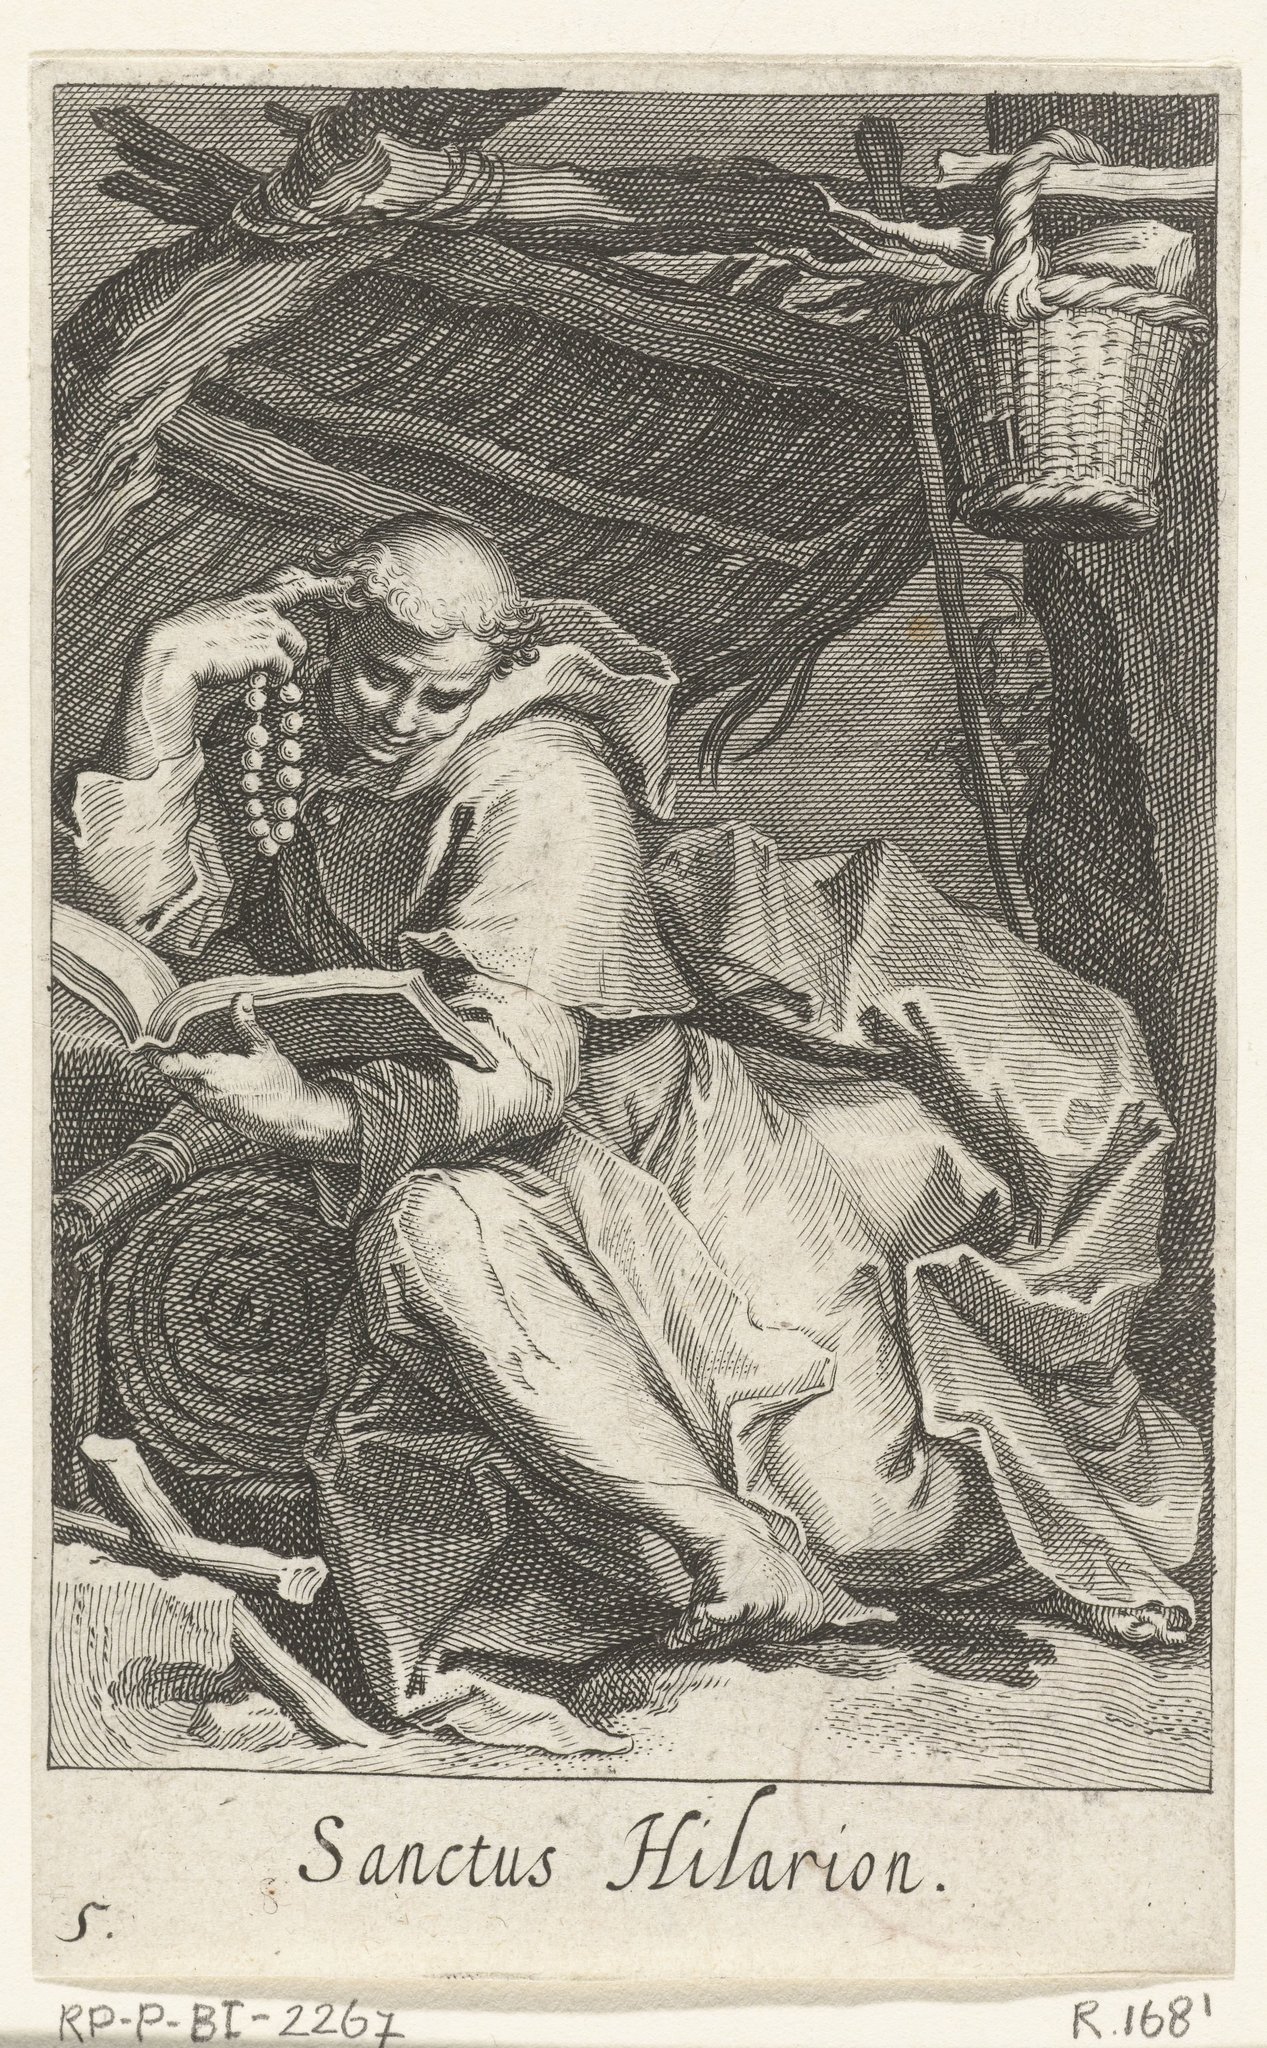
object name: book illustration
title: Kluizenaars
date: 1590-1612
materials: paper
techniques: engraving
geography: antwerp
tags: anchorite, hermit, hilary (hilarius), bishop of poitiers; possible attributes: serpent(s)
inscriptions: collector's mark: Lugt 240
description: Prent uit: Sacra eremus ascetarum, Antwerpen, Hendrick Aertssen, 1619. Eerste gebonden uitgave met in totaal vijftig prenten. Prent uit serie van vijfentwintig mannelijke kluizenaars. In 1612 verscheen een ongebonden editie maar op basis van de gewijzigde opschriften en samenstelling wordt aangenomen dat de prenten van de uitgave 1619 ook in 1612 of iets daarvoor gedrukt werden. Roethlisberger beschouwt de uitgave van 1619 als de eerste staat en de ongebonden editie van 1612 als de tweede staat (Roethlisberger 1993, p. 171, 172).